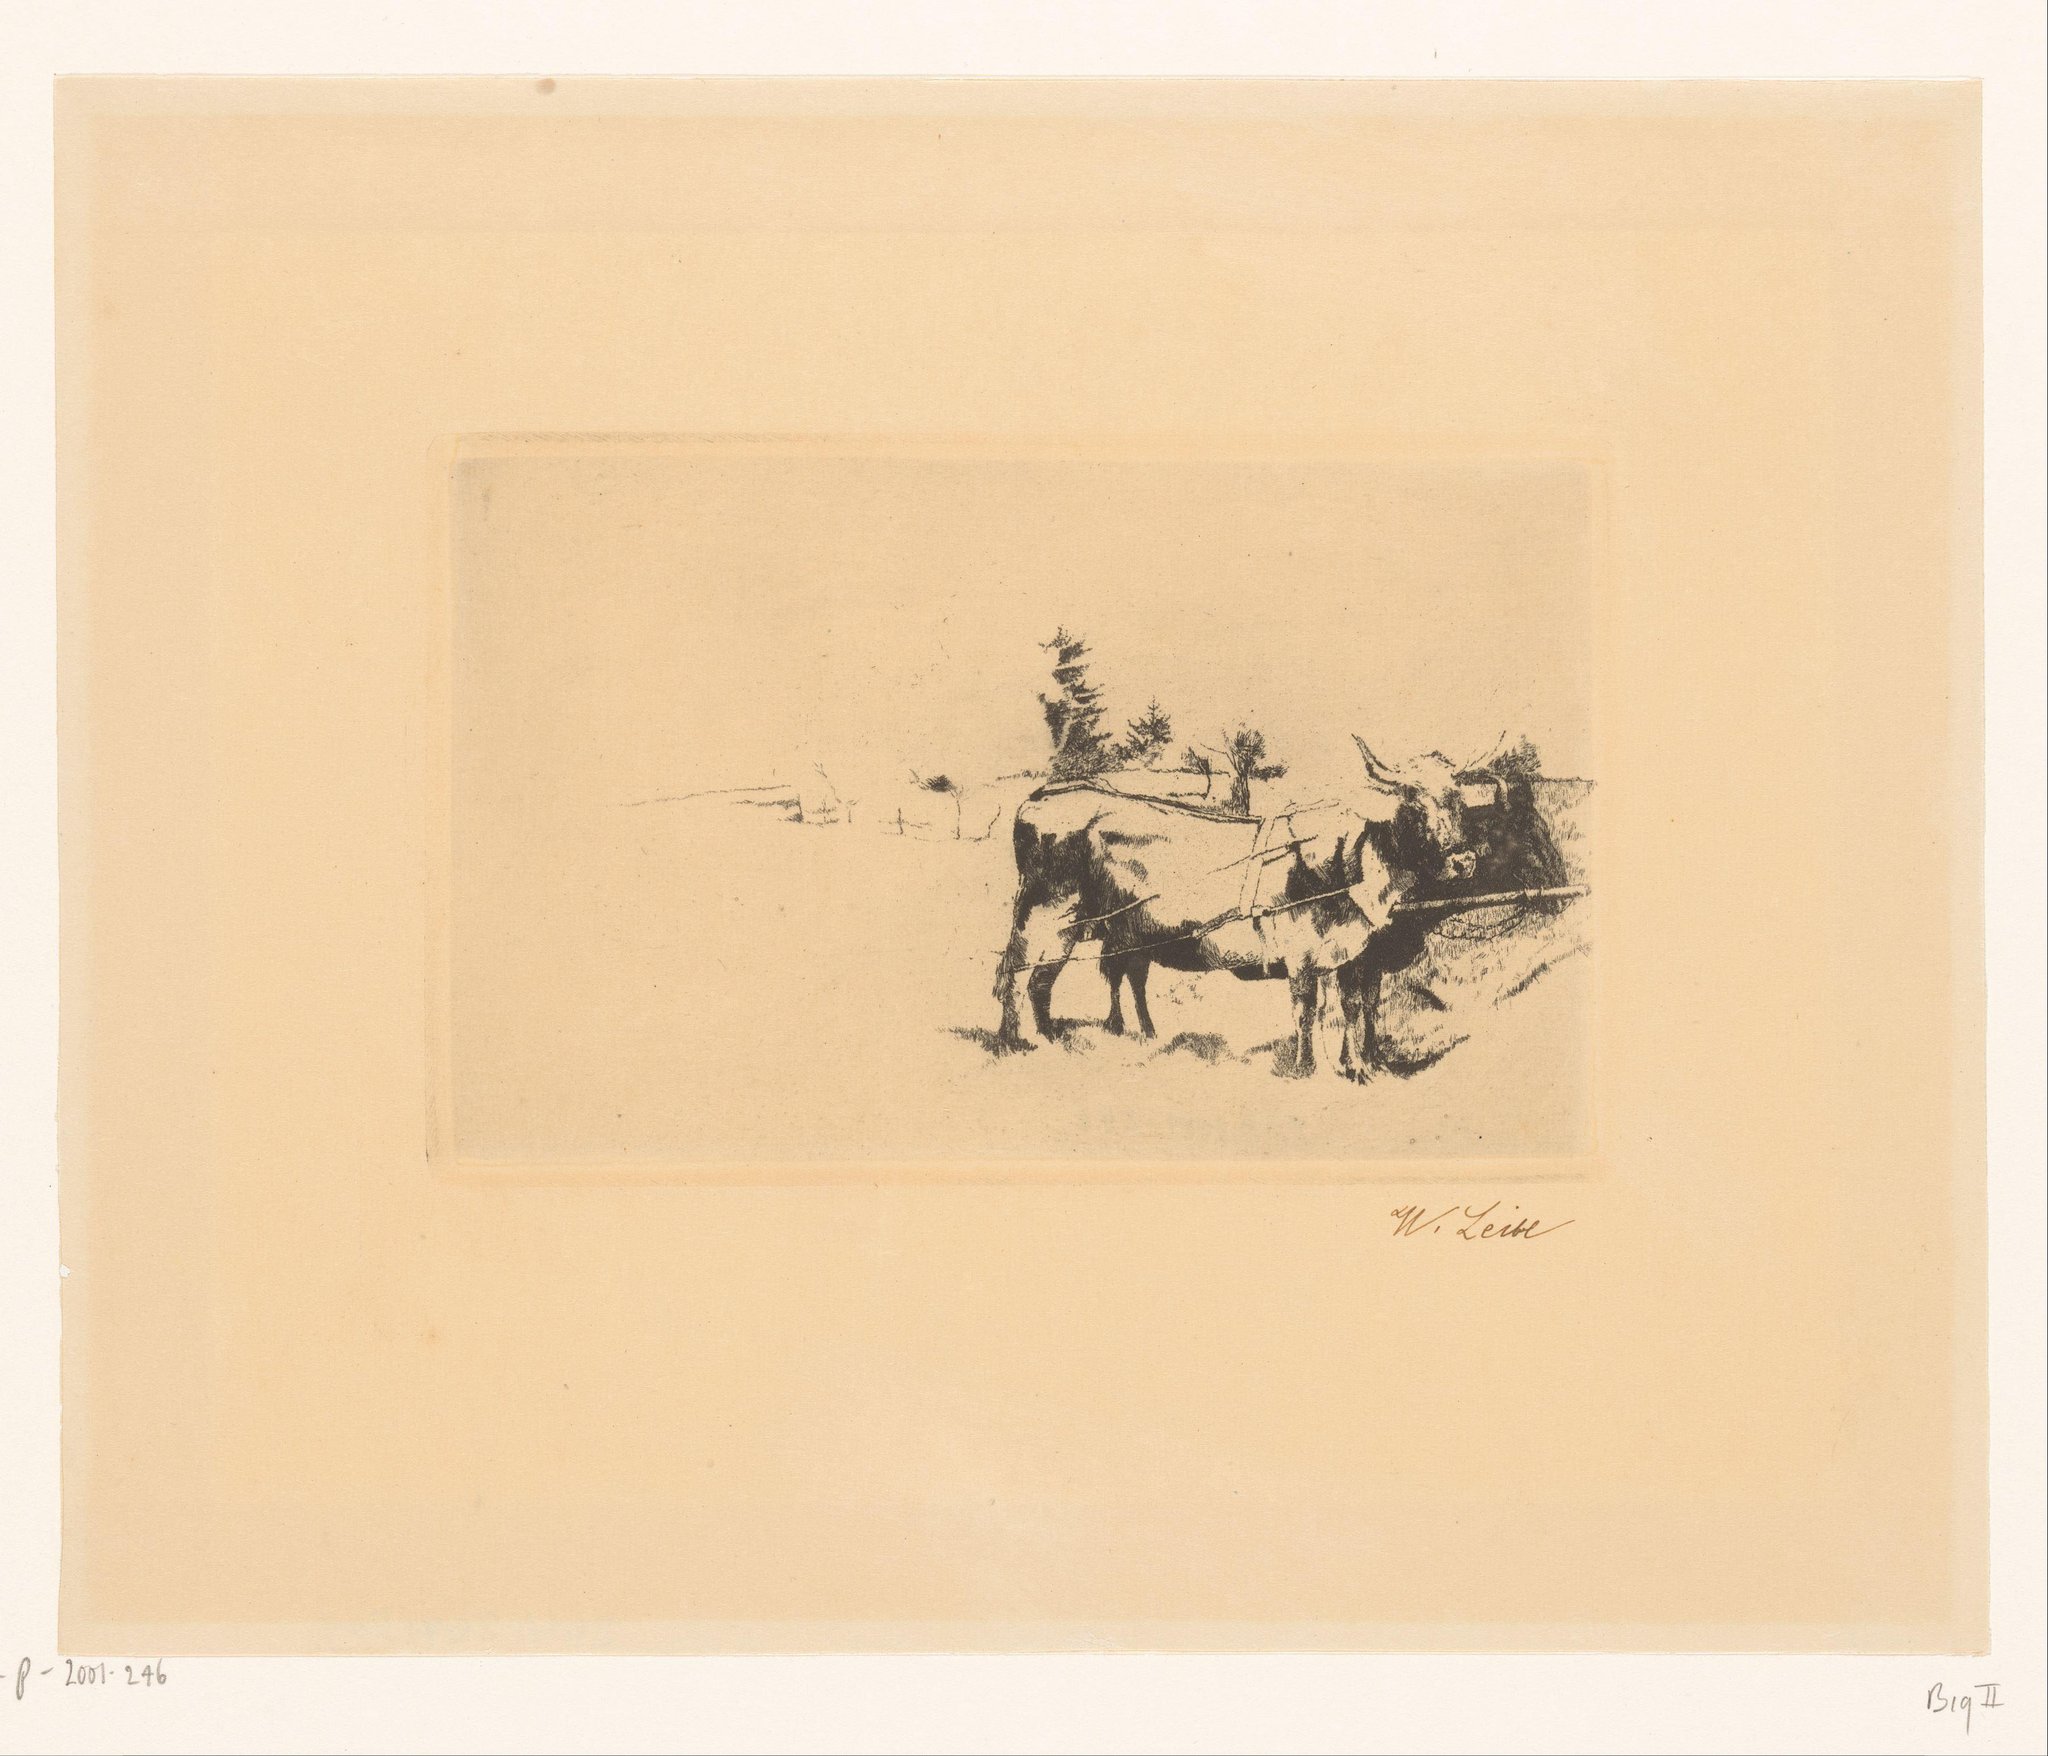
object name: print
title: Os in tuig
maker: wilhelm maria hubertus leibl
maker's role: print maker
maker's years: 1844-1900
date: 1875-1877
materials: paper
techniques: etching, intaglio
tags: ox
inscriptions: collector's mark: Lugt 2760, collector's mark: Lugt 2228